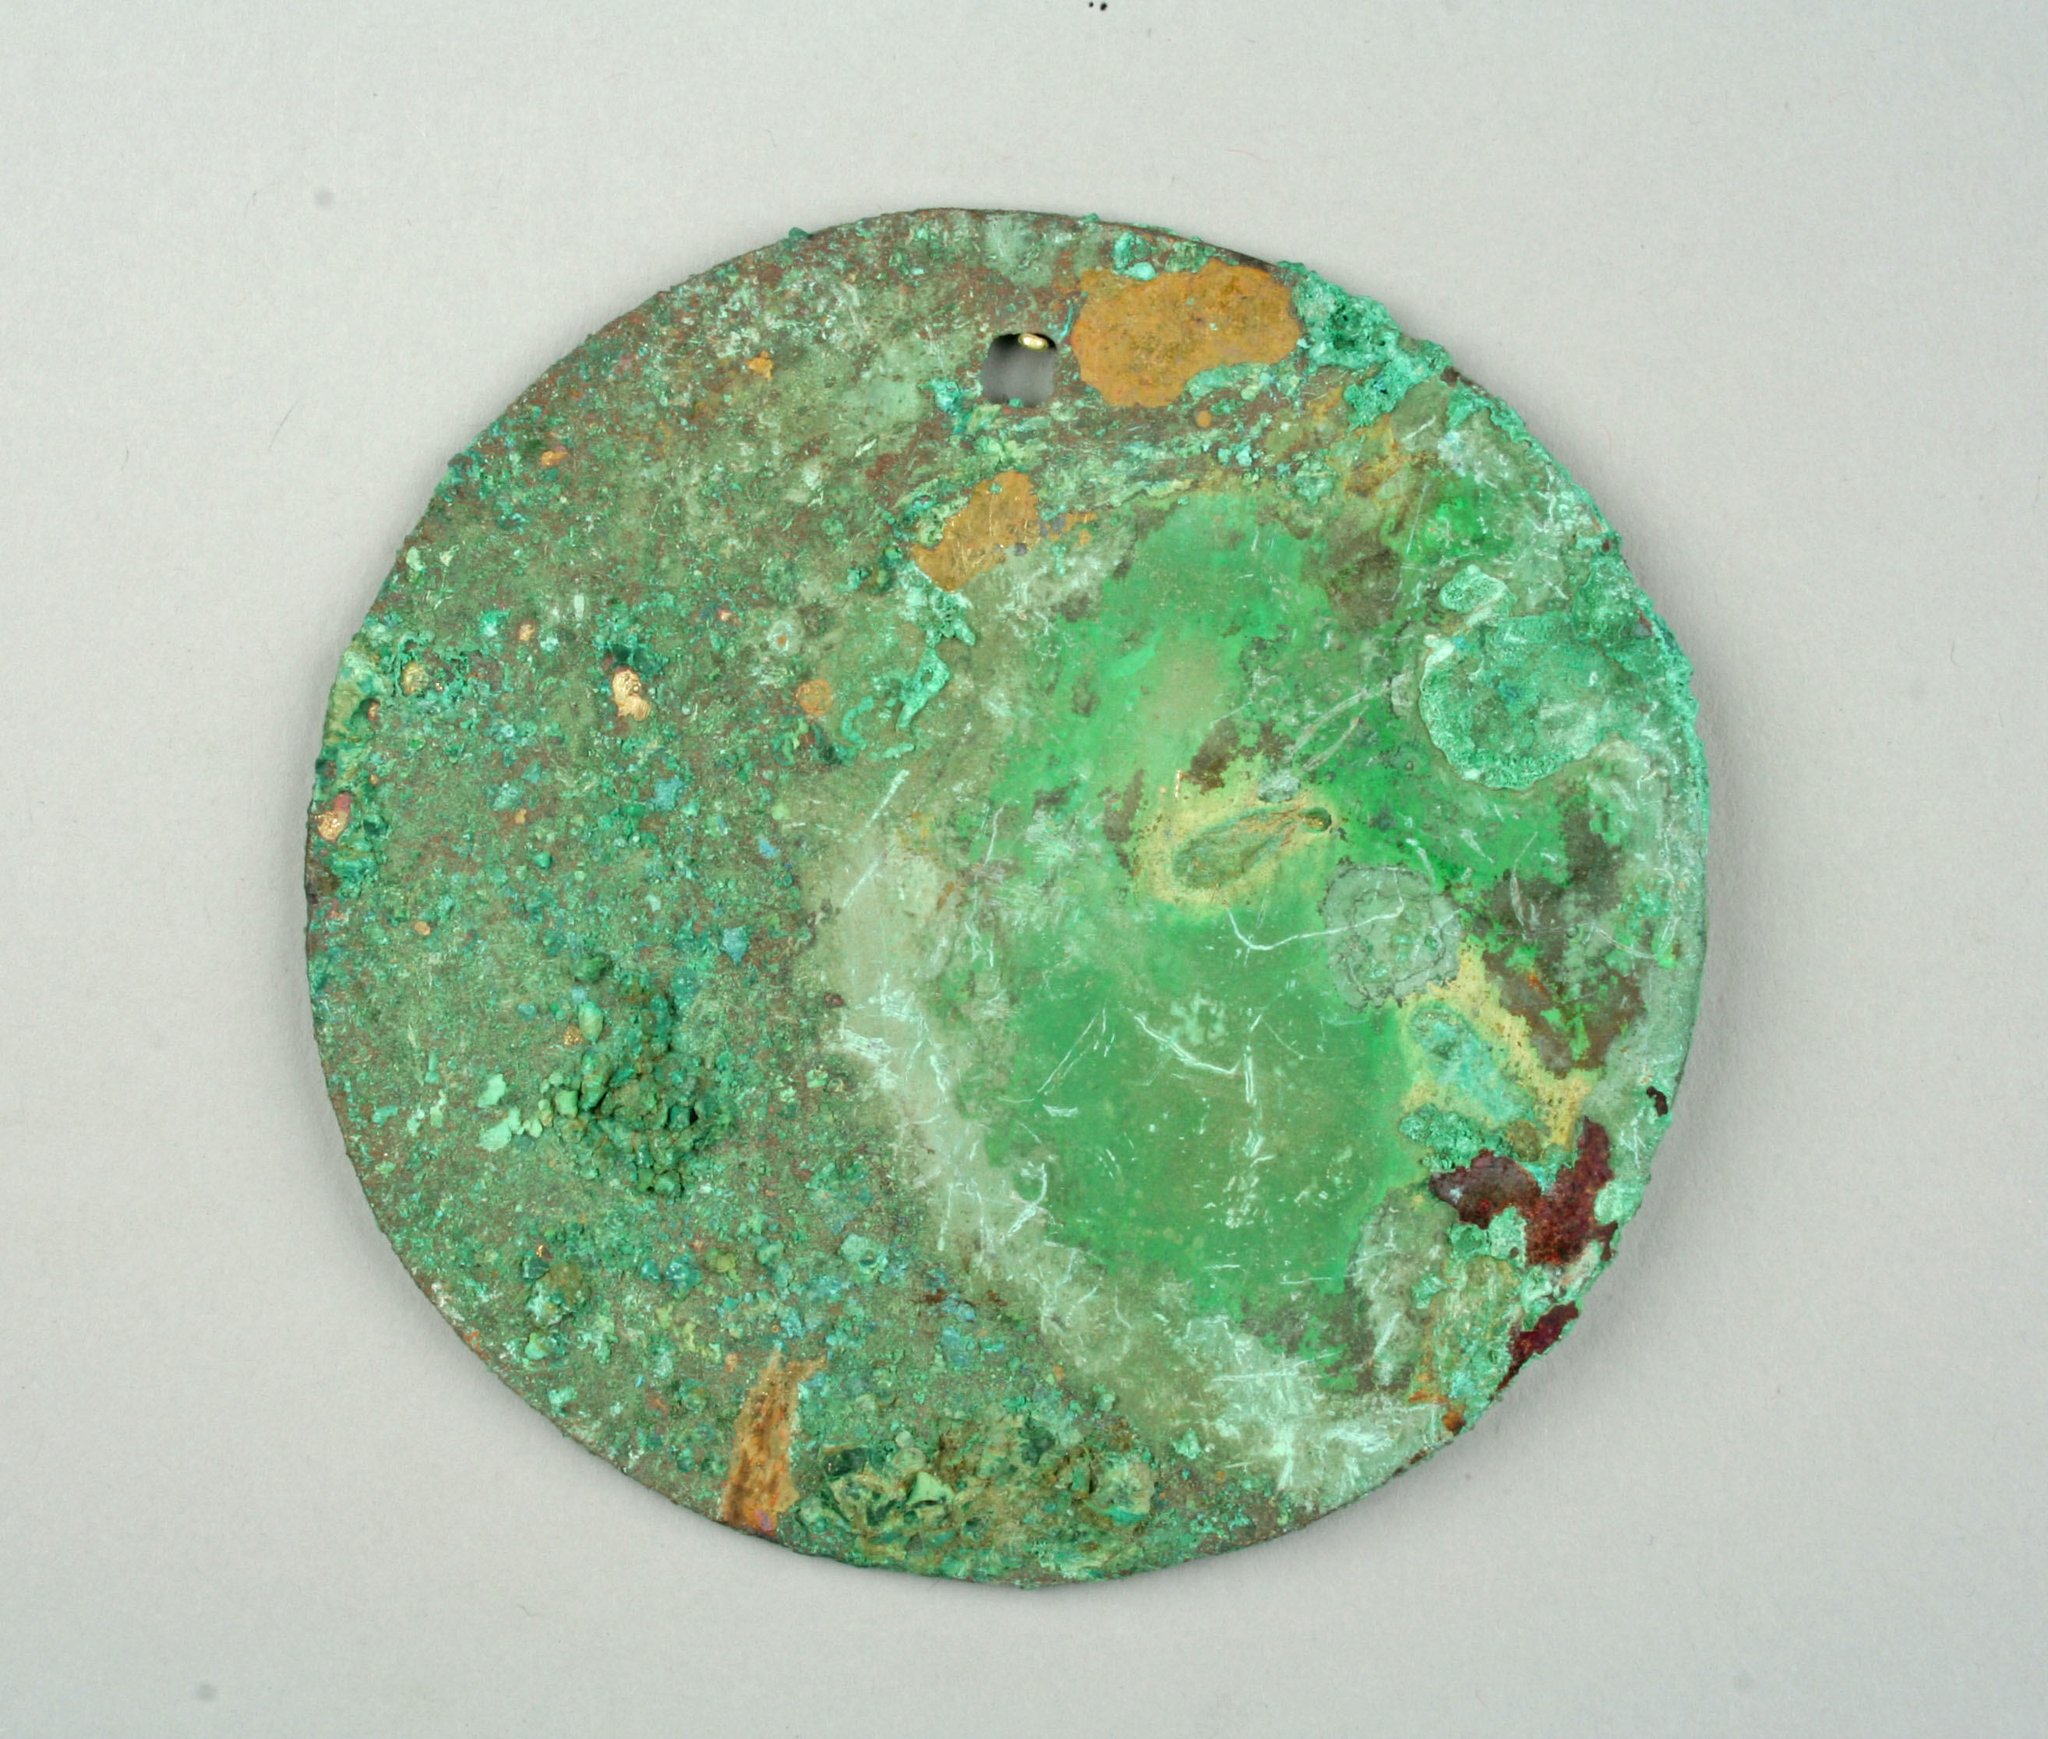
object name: plaque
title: Round Plaque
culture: vicús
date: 300 BCE-200 CE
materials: copper, gilt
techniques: hammering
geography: peru